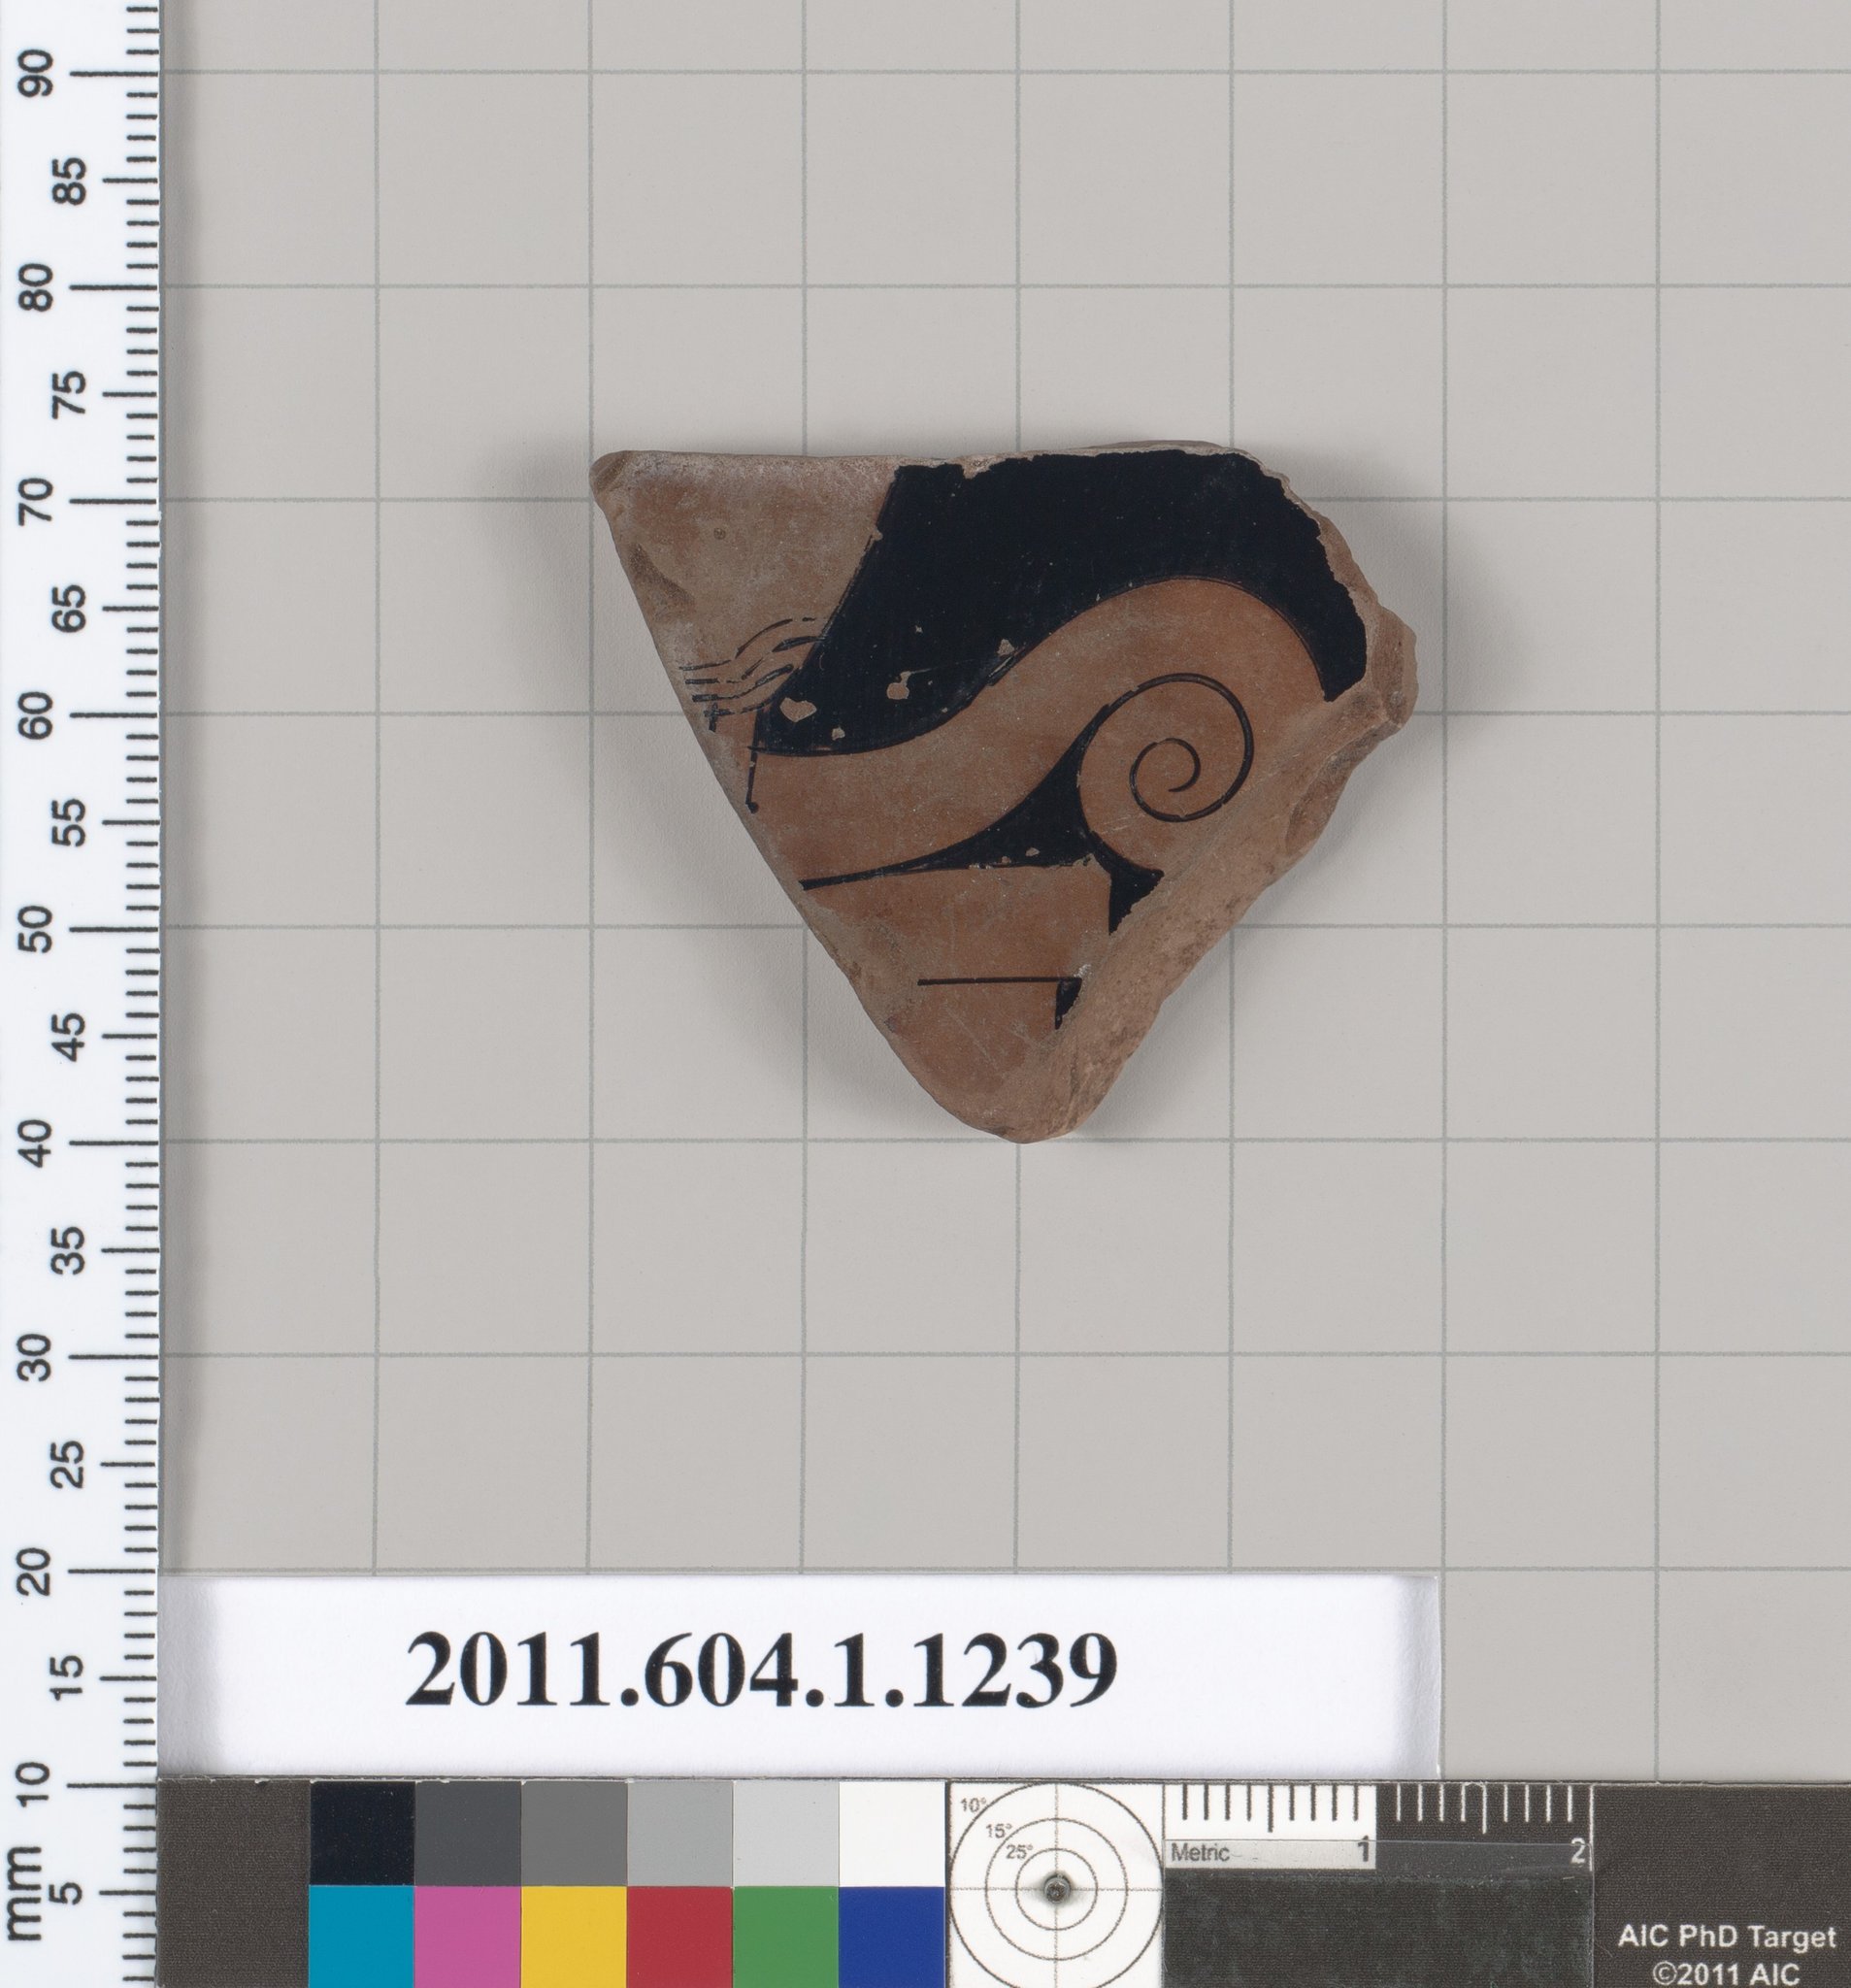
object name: kylix fragment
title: Terracotta fragment of a kylix (drinking cup)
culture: greek, attic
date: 475-451 BCE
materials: terracotta